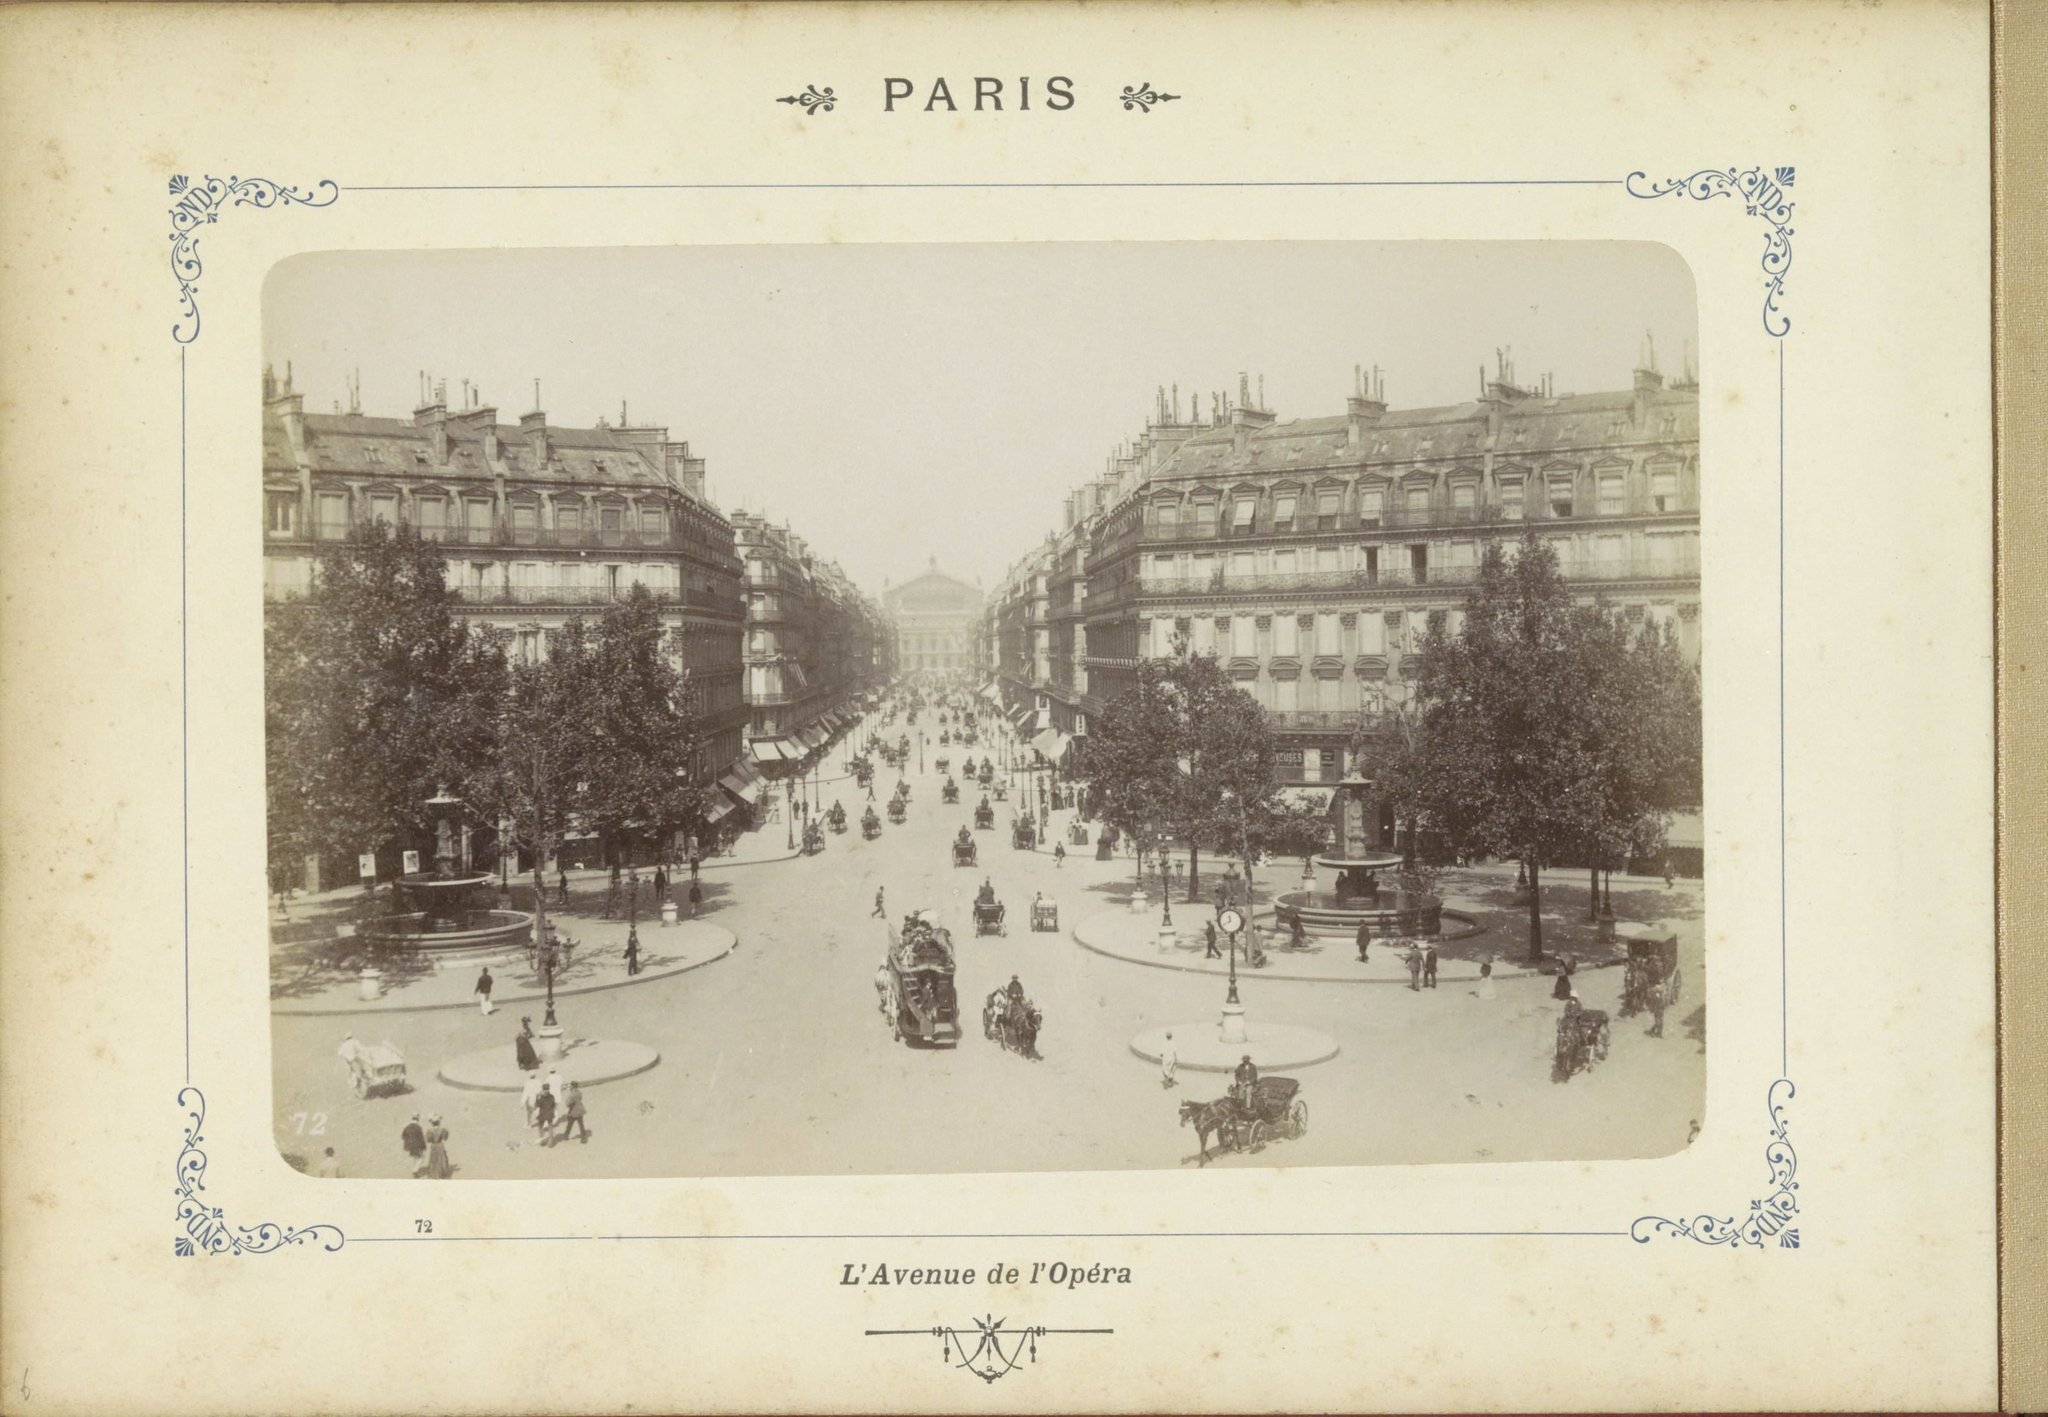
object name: photograph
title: Paris - L'Avenue de l'Opéra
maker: Anonymous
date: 1900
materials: cardboard, paper, photographic support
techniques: albumen print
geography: paris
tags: avenue, boulevard, promenade, esplanade (+ city(-scape) with figures, staffage), paris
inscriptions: number: ‘72’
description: Onderdeel van Fotoalbum met bezienswaardigheden in Parijs, Versailles en het Bois de Boulogne.